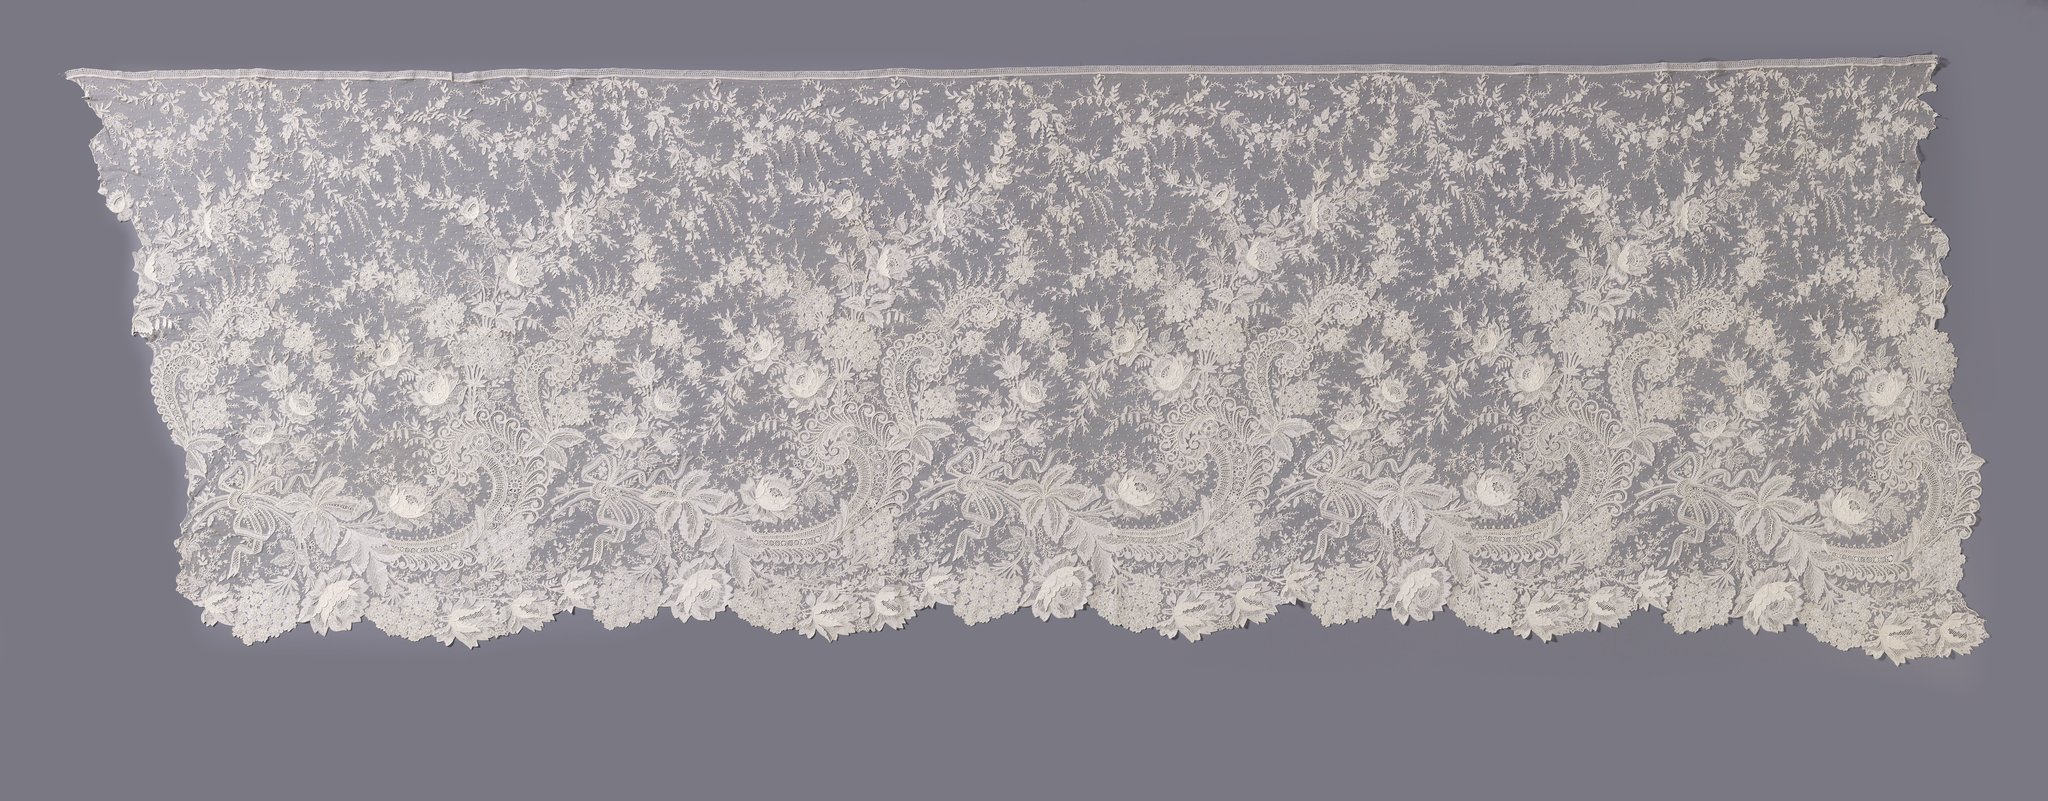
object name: strip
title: Strook naaldkant met gestrikt boeket en sneeuwballen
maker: Anonymous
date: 1870-1890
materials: linen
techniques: lace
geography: brussels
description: Strook naturelkleurige naaldkant: Brusselse gaaskant. Strooipatroon van moesjes op een maasgrond. Hierop tekent een zich herhalend patroon af dat onderaan bestaat uit een liggend en gestrikt boeket. Het boeket bestaat uit grote takken met forse rozen en sneeuwballen, die naar boven en beneden buigen. In het verlengde van het liggende boeket is een zeer forse en rijk bewerkte c-voluut geplaatst, waaruit de top ook weer bloemtakken ontspringen. Het patroon wordt naar de bovenkant toe ijler, met kleinere motieven en bestaat uit golvende bloemslingers. Volwerk met uitsparingen, reliëfcontouren met deels sterk verdikte kordons en een verscheidenheid aan siergronden en siersteken. De geschulpte rand komt voort uit het patroon. De bovenzijde is afgezet met een rand kloskant. De zijkanten zijn afgewerkt met een zoompje, waarbij deels de vorm van de motieven gevolgd wordt.